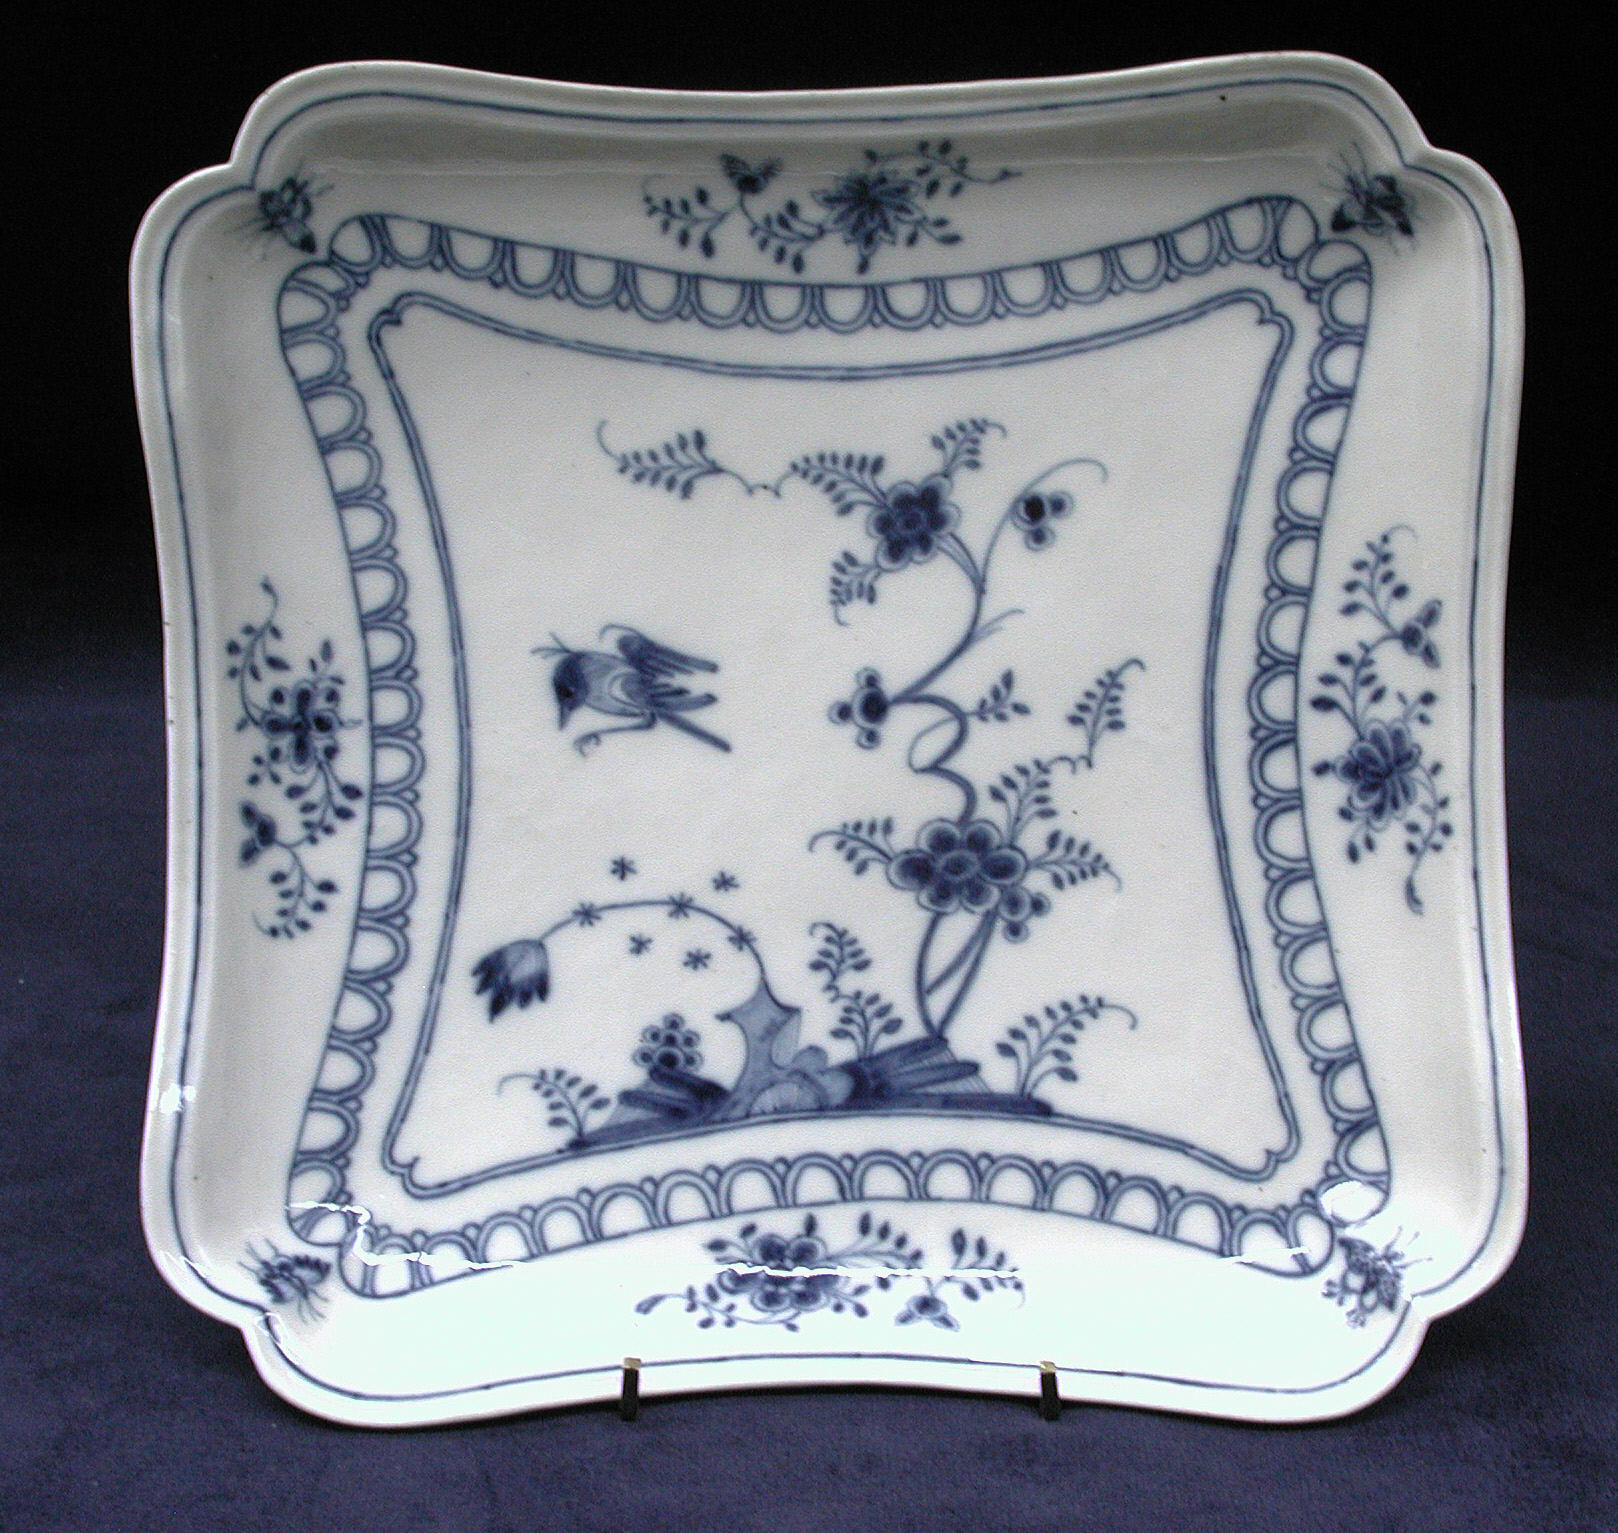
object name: dish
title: Square dish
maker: ansbach pottery and porcelain manufactory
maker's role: manufactory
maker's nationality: german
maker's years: 1758-1860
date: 1780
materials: hard paste porcelain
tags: birds,flowers